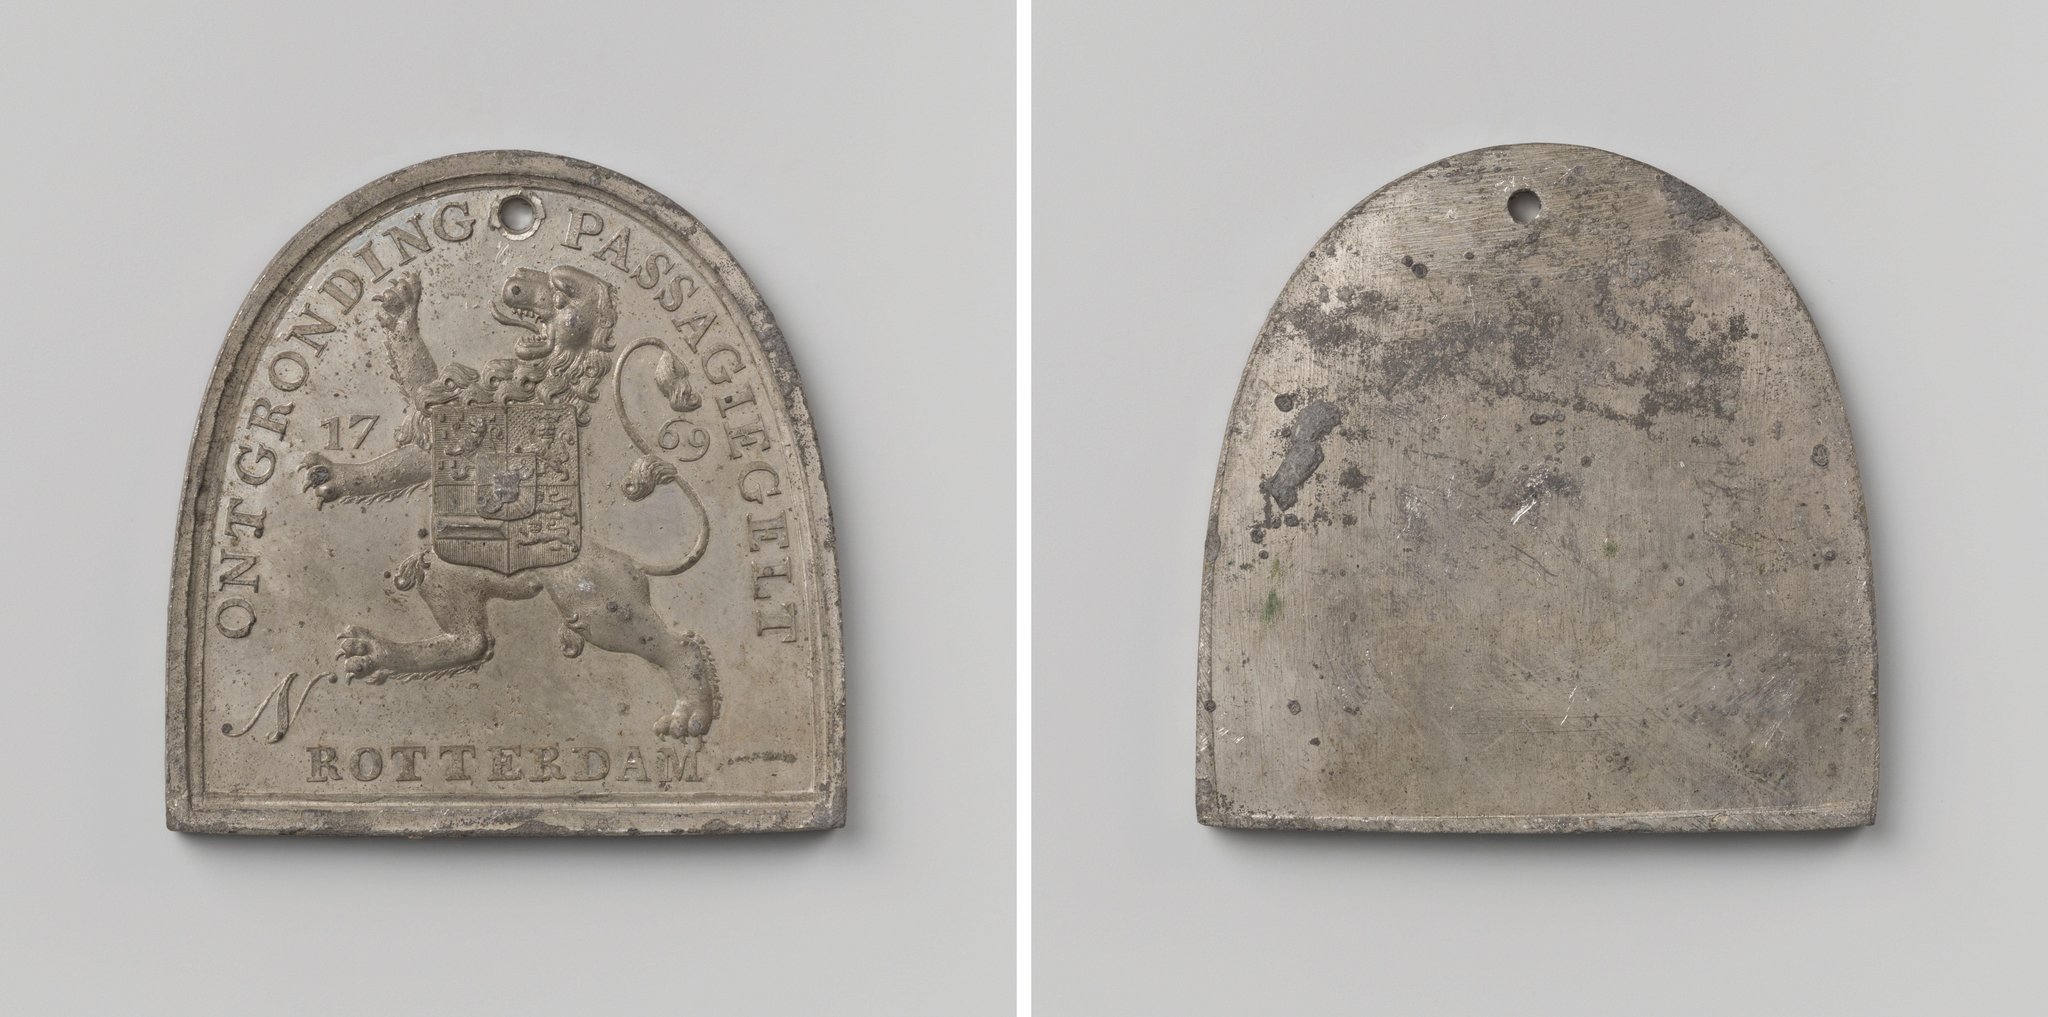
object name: identification medal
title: Ontgronding te Rotterdam, penning bedoeld als bewijs voor turfdragers, -vullers of -tonners om turf in te mogen voeren uit de nieuw ontgronde venen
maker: Anonymous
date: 1769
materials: lead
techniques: casting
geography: rotterdam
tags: rotterdam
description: Eenzijdige loden penning met ronde boven- en rechthoekige onderzijde, en gat erin. Voorzijde: staande leeuw met wapenschild op borst tussen jaartal binnen omschrift. Keerzijde: blanco.